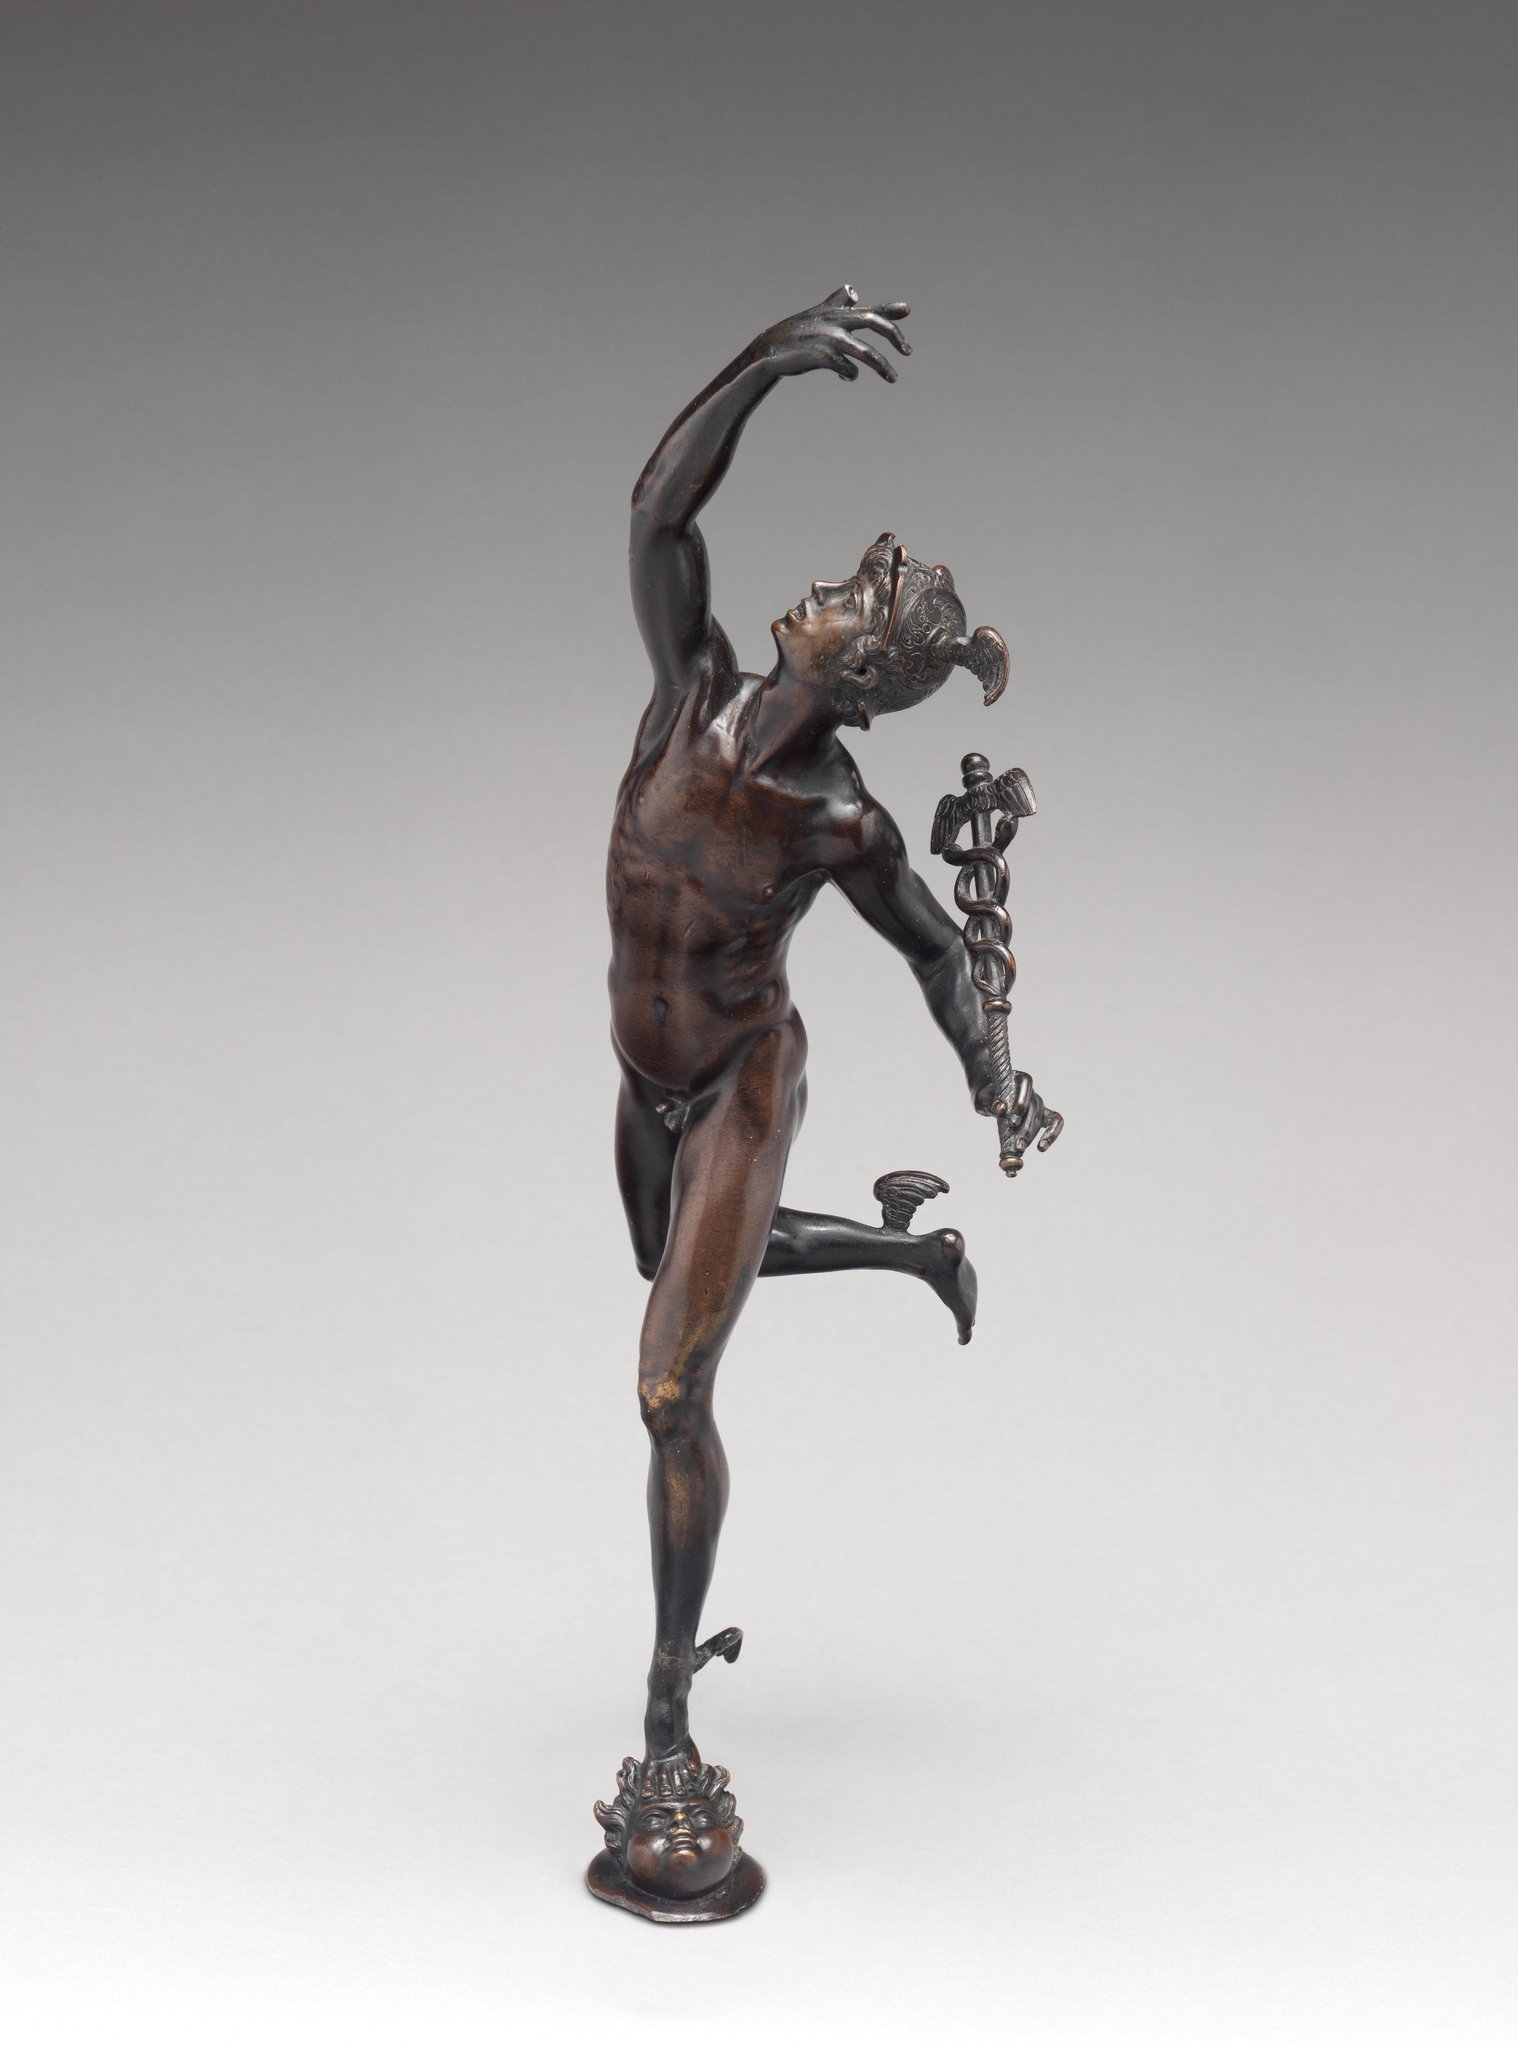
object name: statuette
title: Mercury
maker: giambologna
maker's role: artist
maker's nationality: netherlandish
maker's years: 1529-1608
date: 1601-1800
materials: bronze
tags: mercury